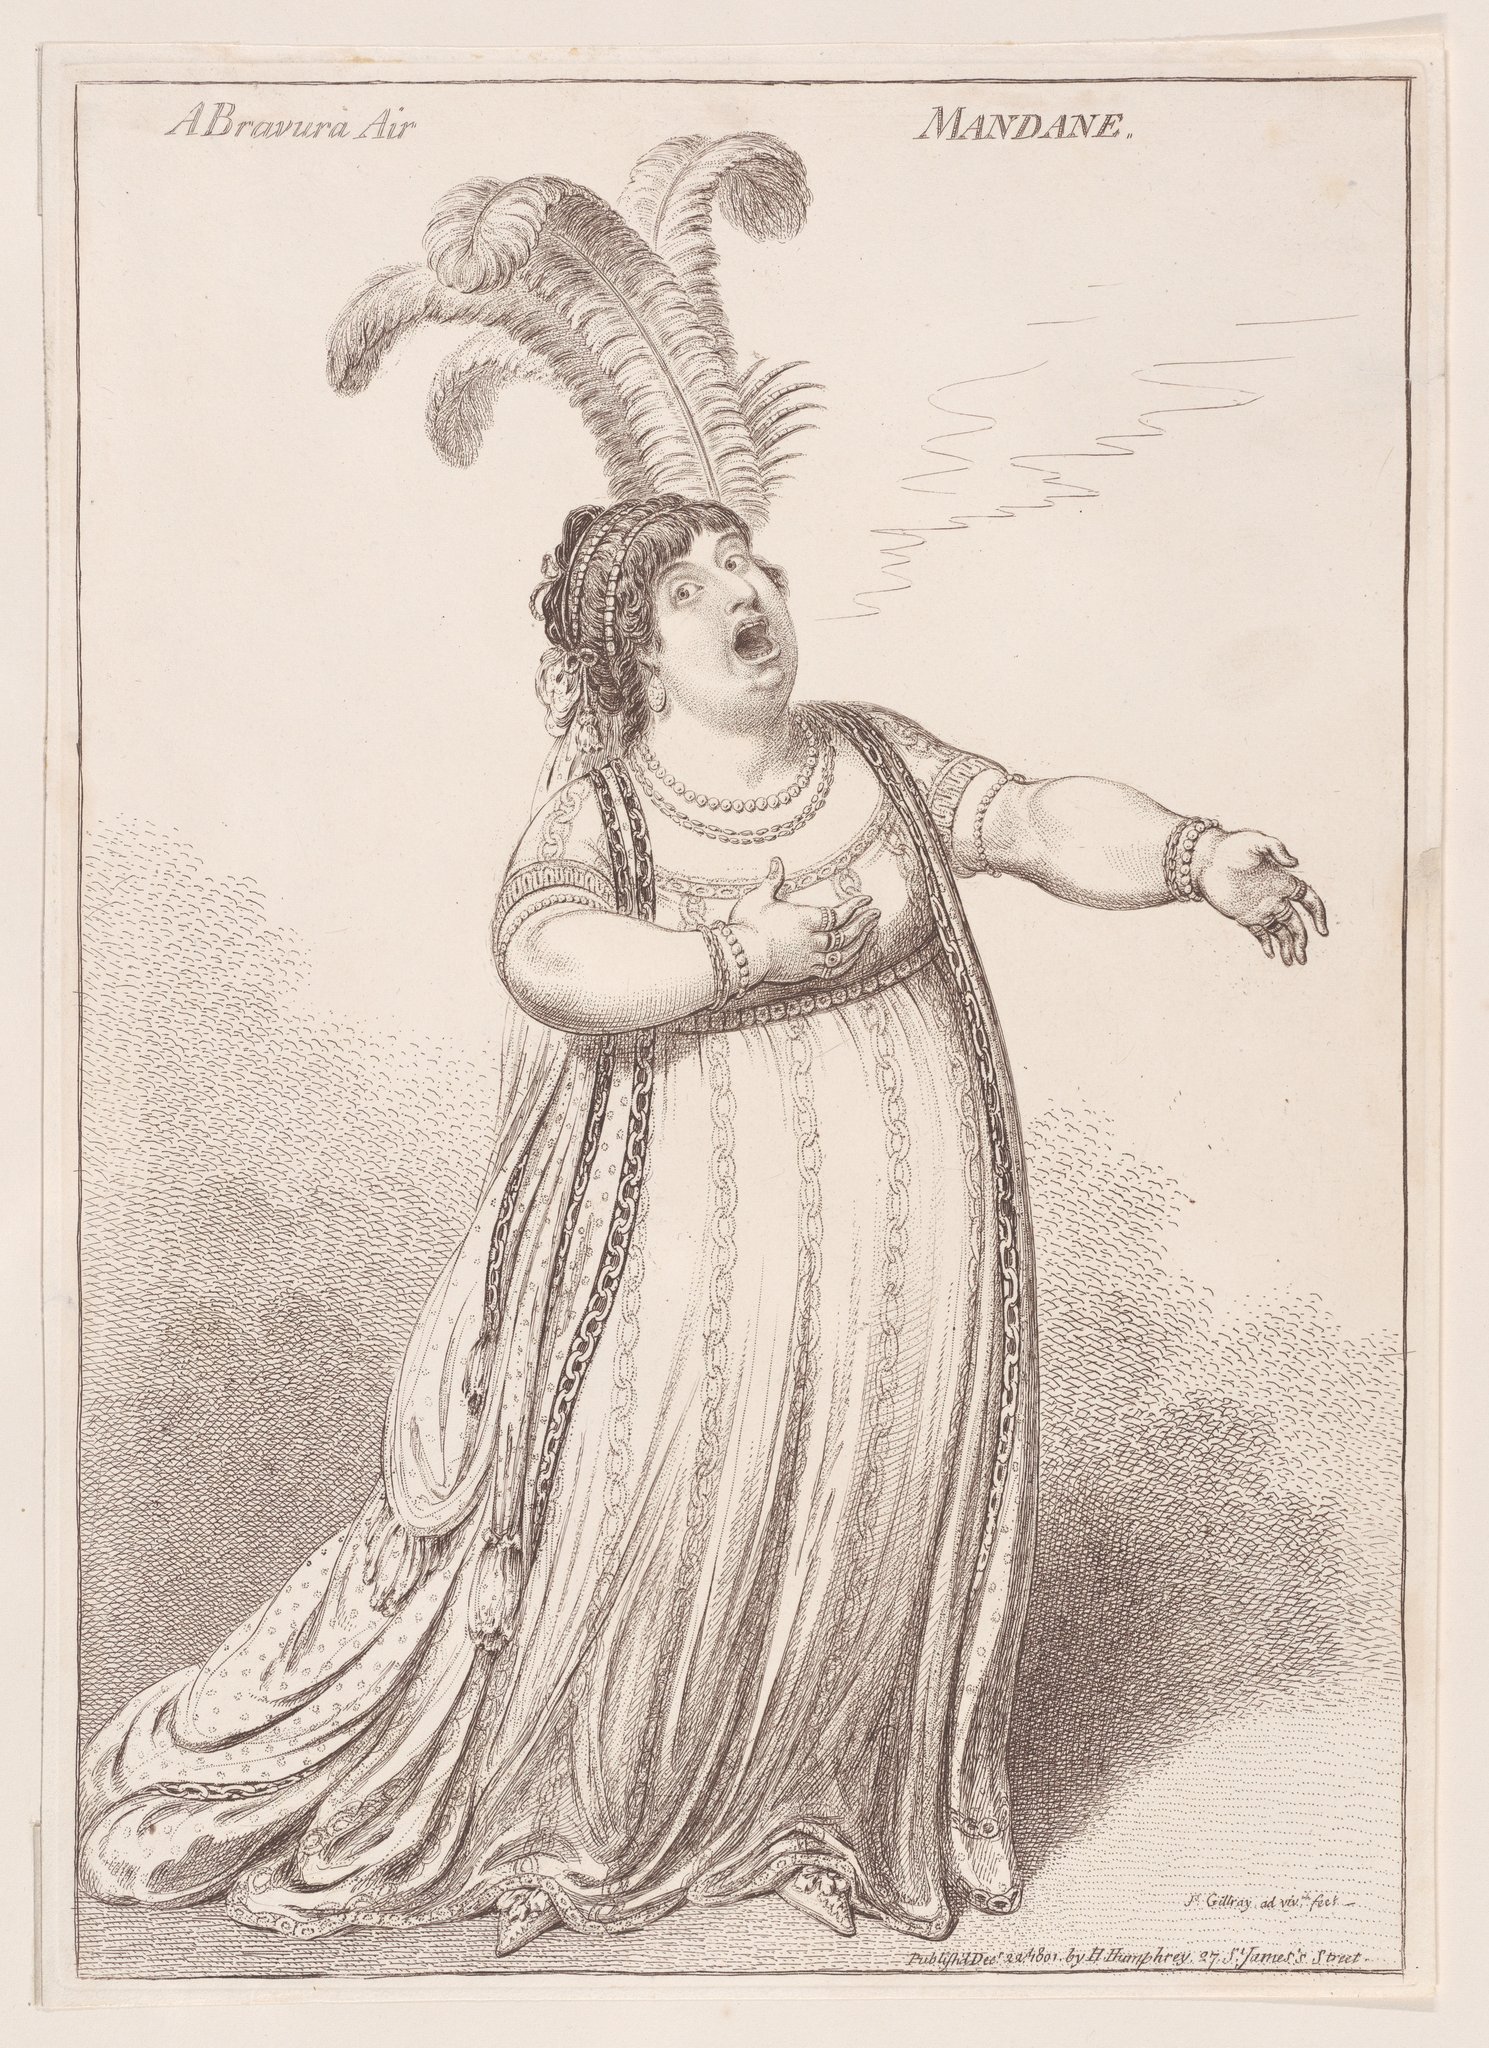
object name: print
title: A Bravura Air. Mandane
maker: james gillray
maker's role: artist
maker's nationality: british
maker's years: 1756-1815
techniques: etching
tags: women,singing,singers,caricature